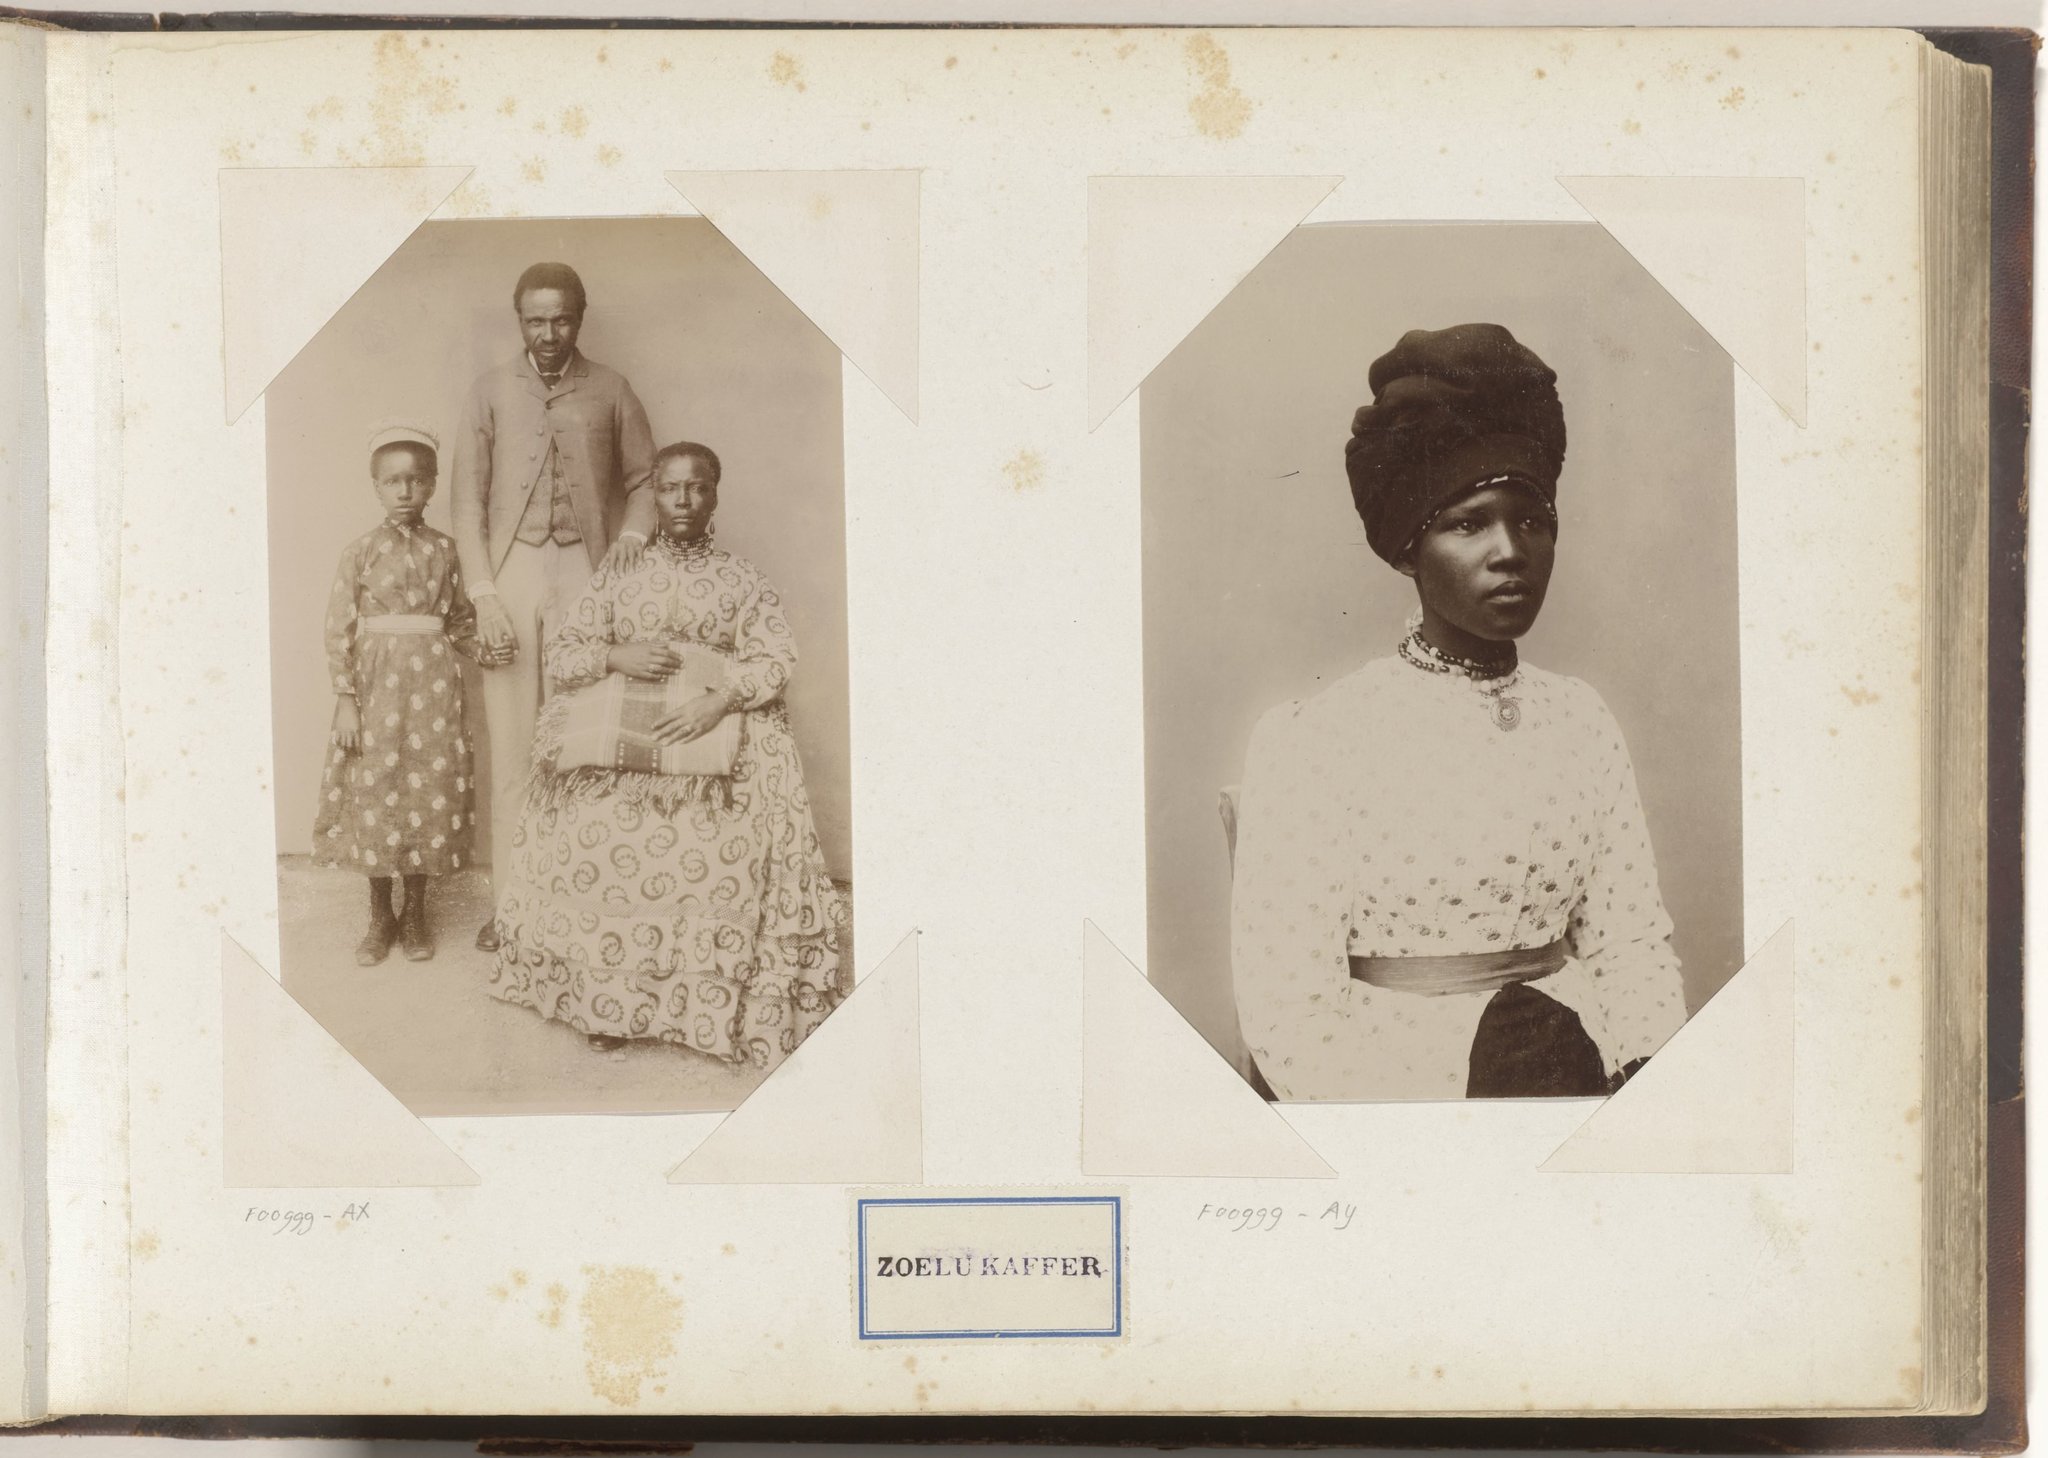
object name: photograph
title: Portret van een Zoeloe-vrouw met tulband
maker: Anonymous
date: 1885-1910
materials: paper, photographic support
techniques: daylight paper print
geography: south africa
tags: africans, head-gear: turban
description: Onderdeel van Album met 191 foto's van een reis naar en door Zuid-Afrika.